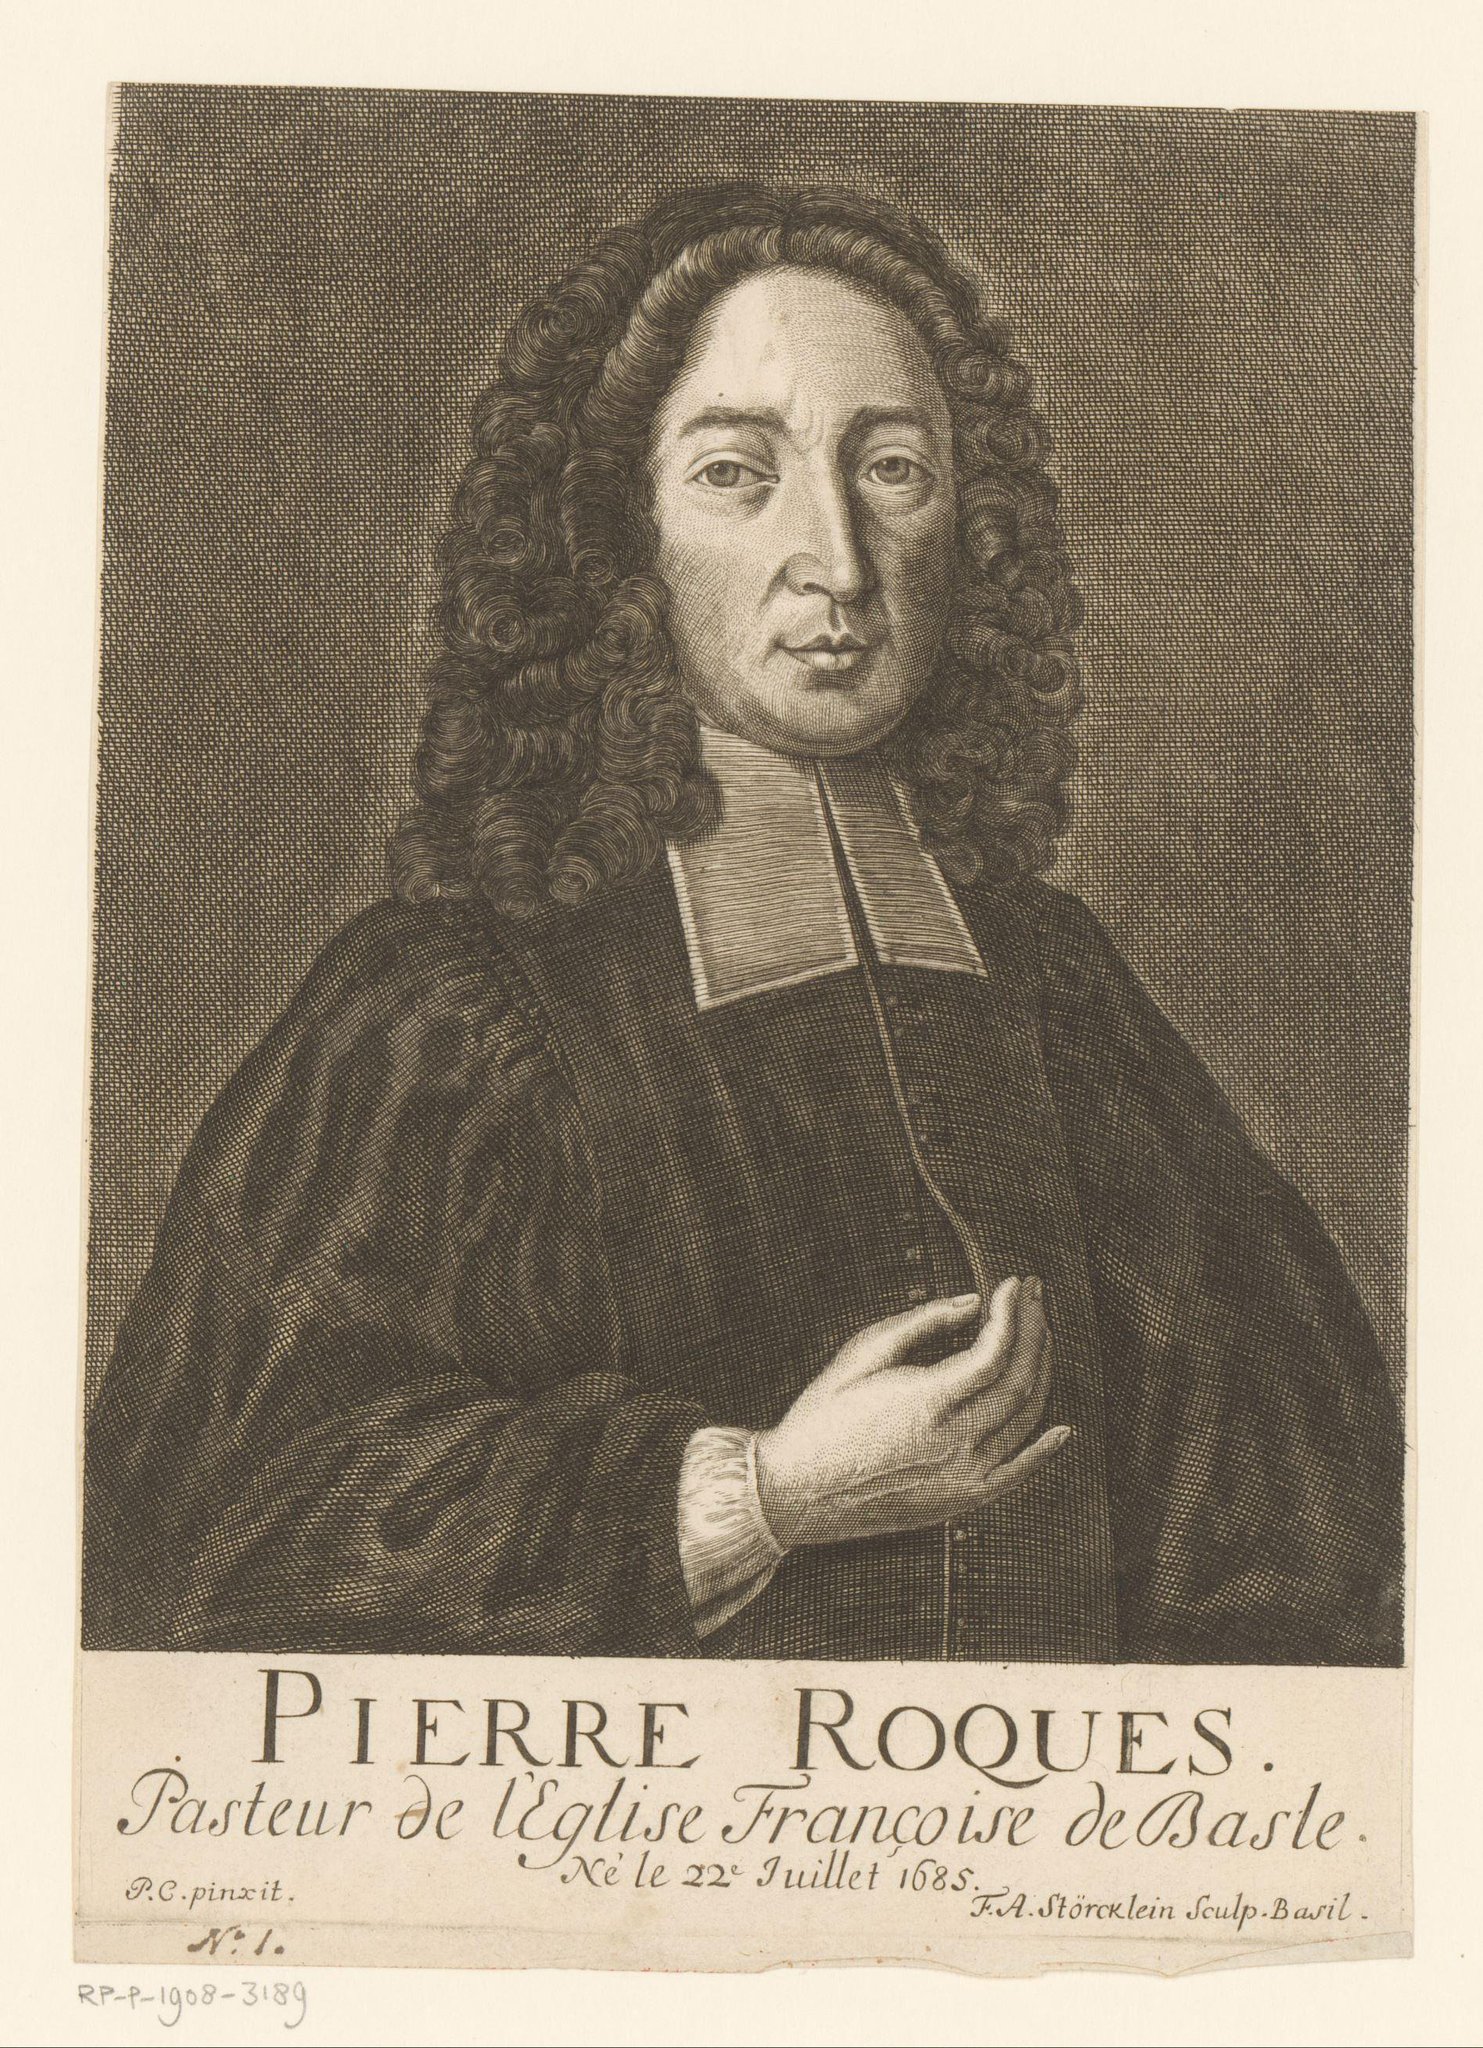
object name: print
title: Portret van Pierre Roques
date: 1715-1730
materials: paper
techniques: engraving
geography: basel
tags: historical persons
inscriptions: collector's mark: Lugt 2228, number: ‘No. 1.’